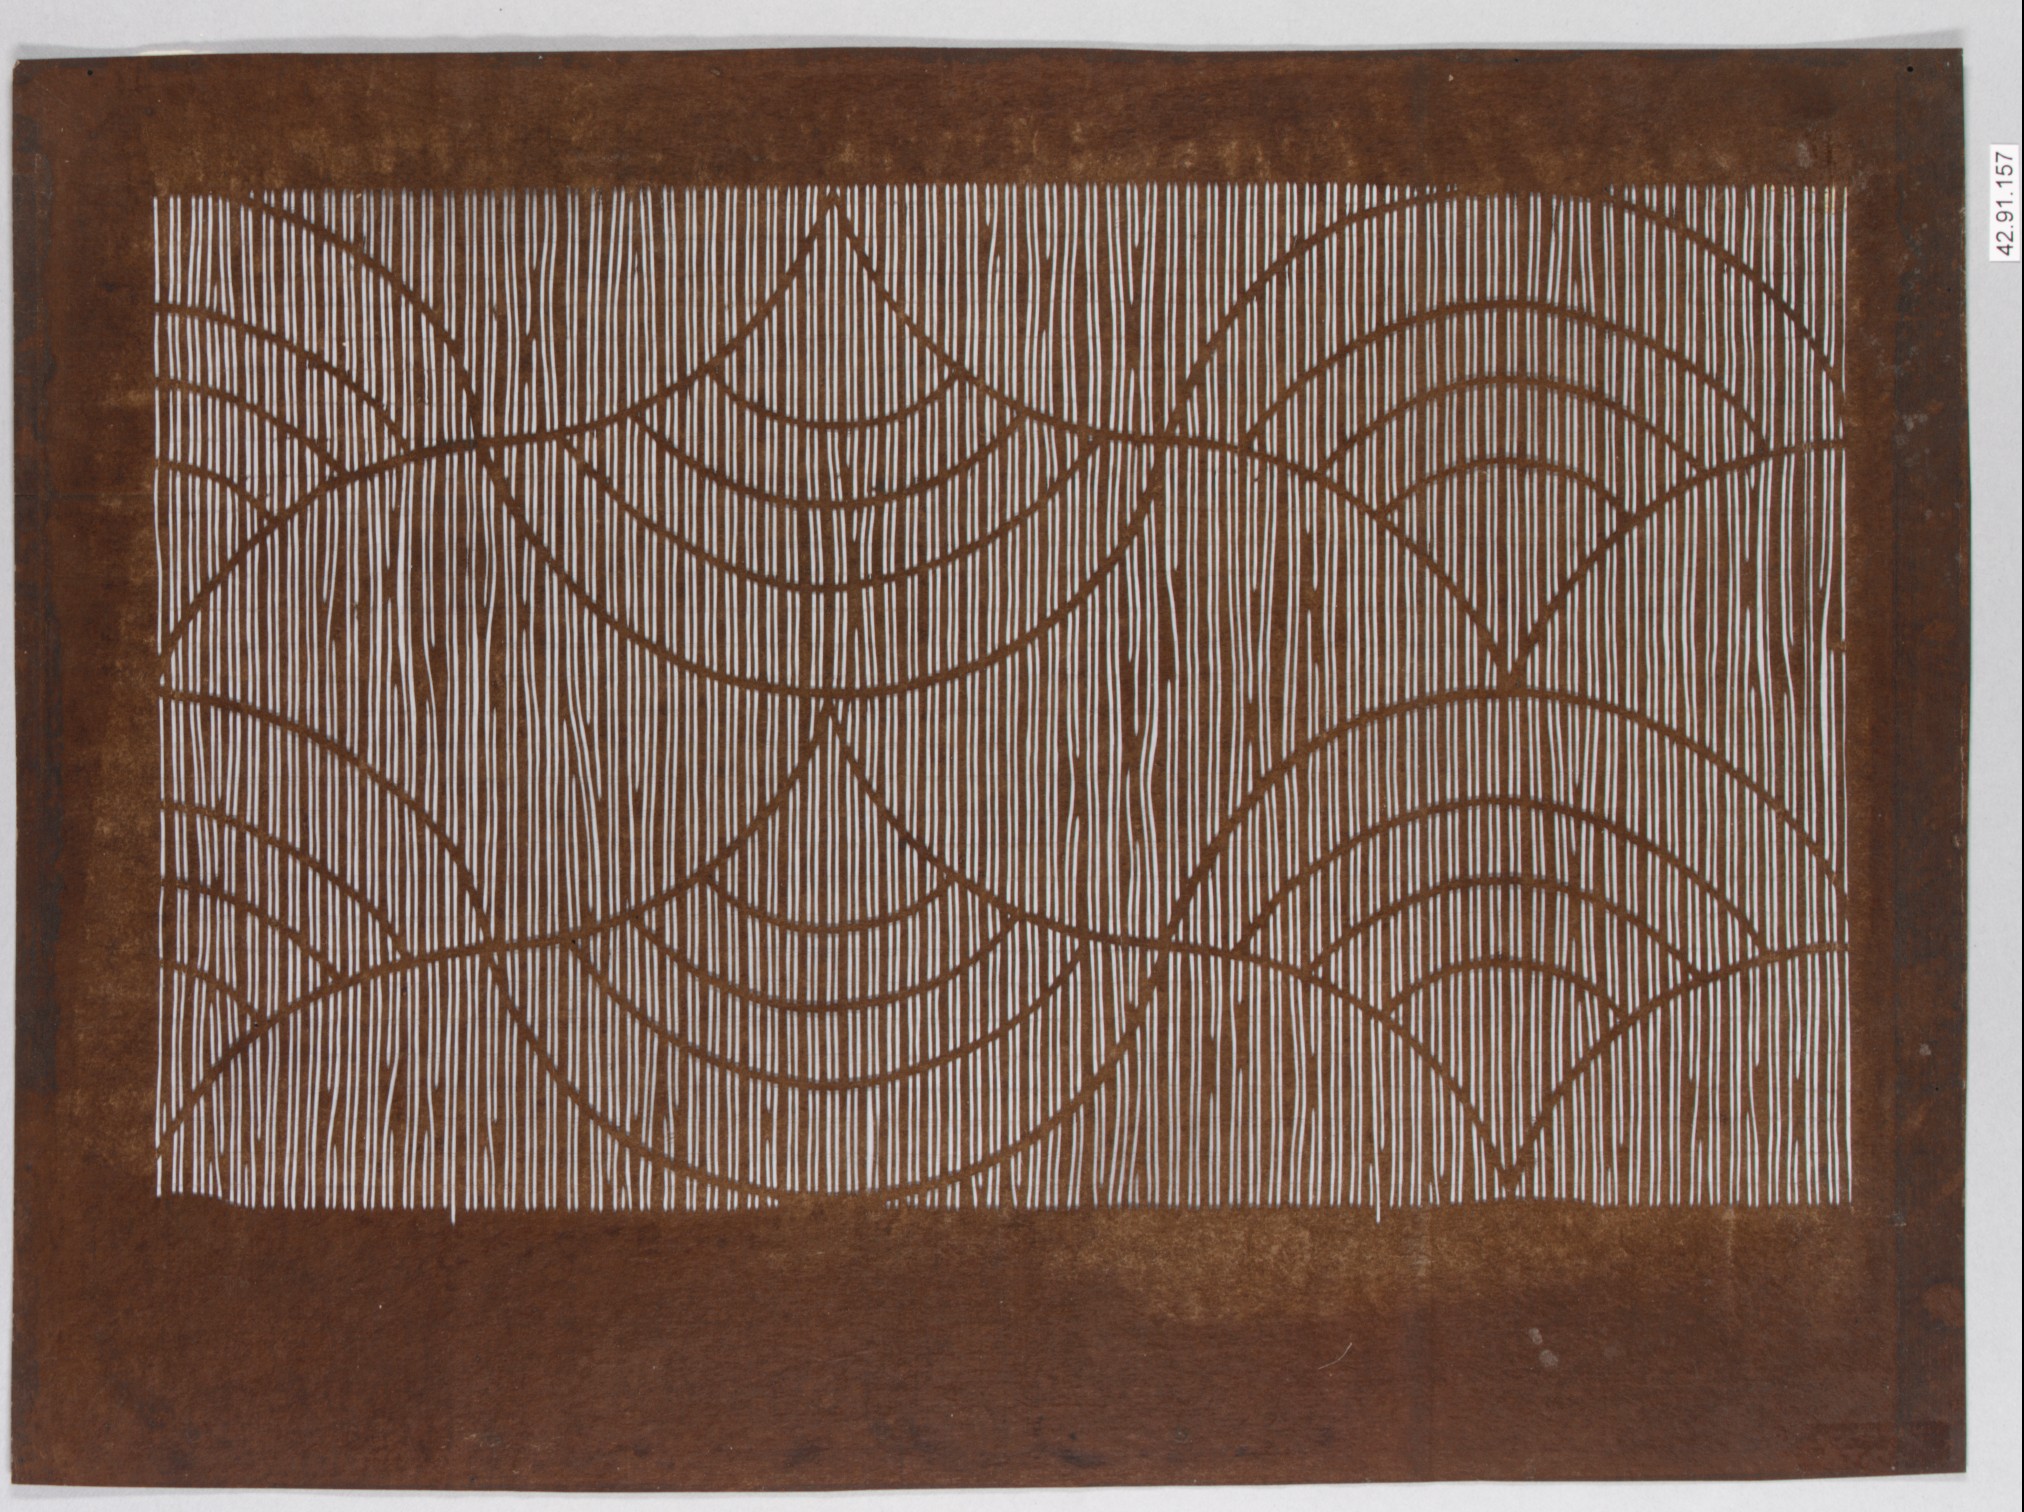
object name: stencil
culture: japanese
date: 1801-1900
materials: paper, silk